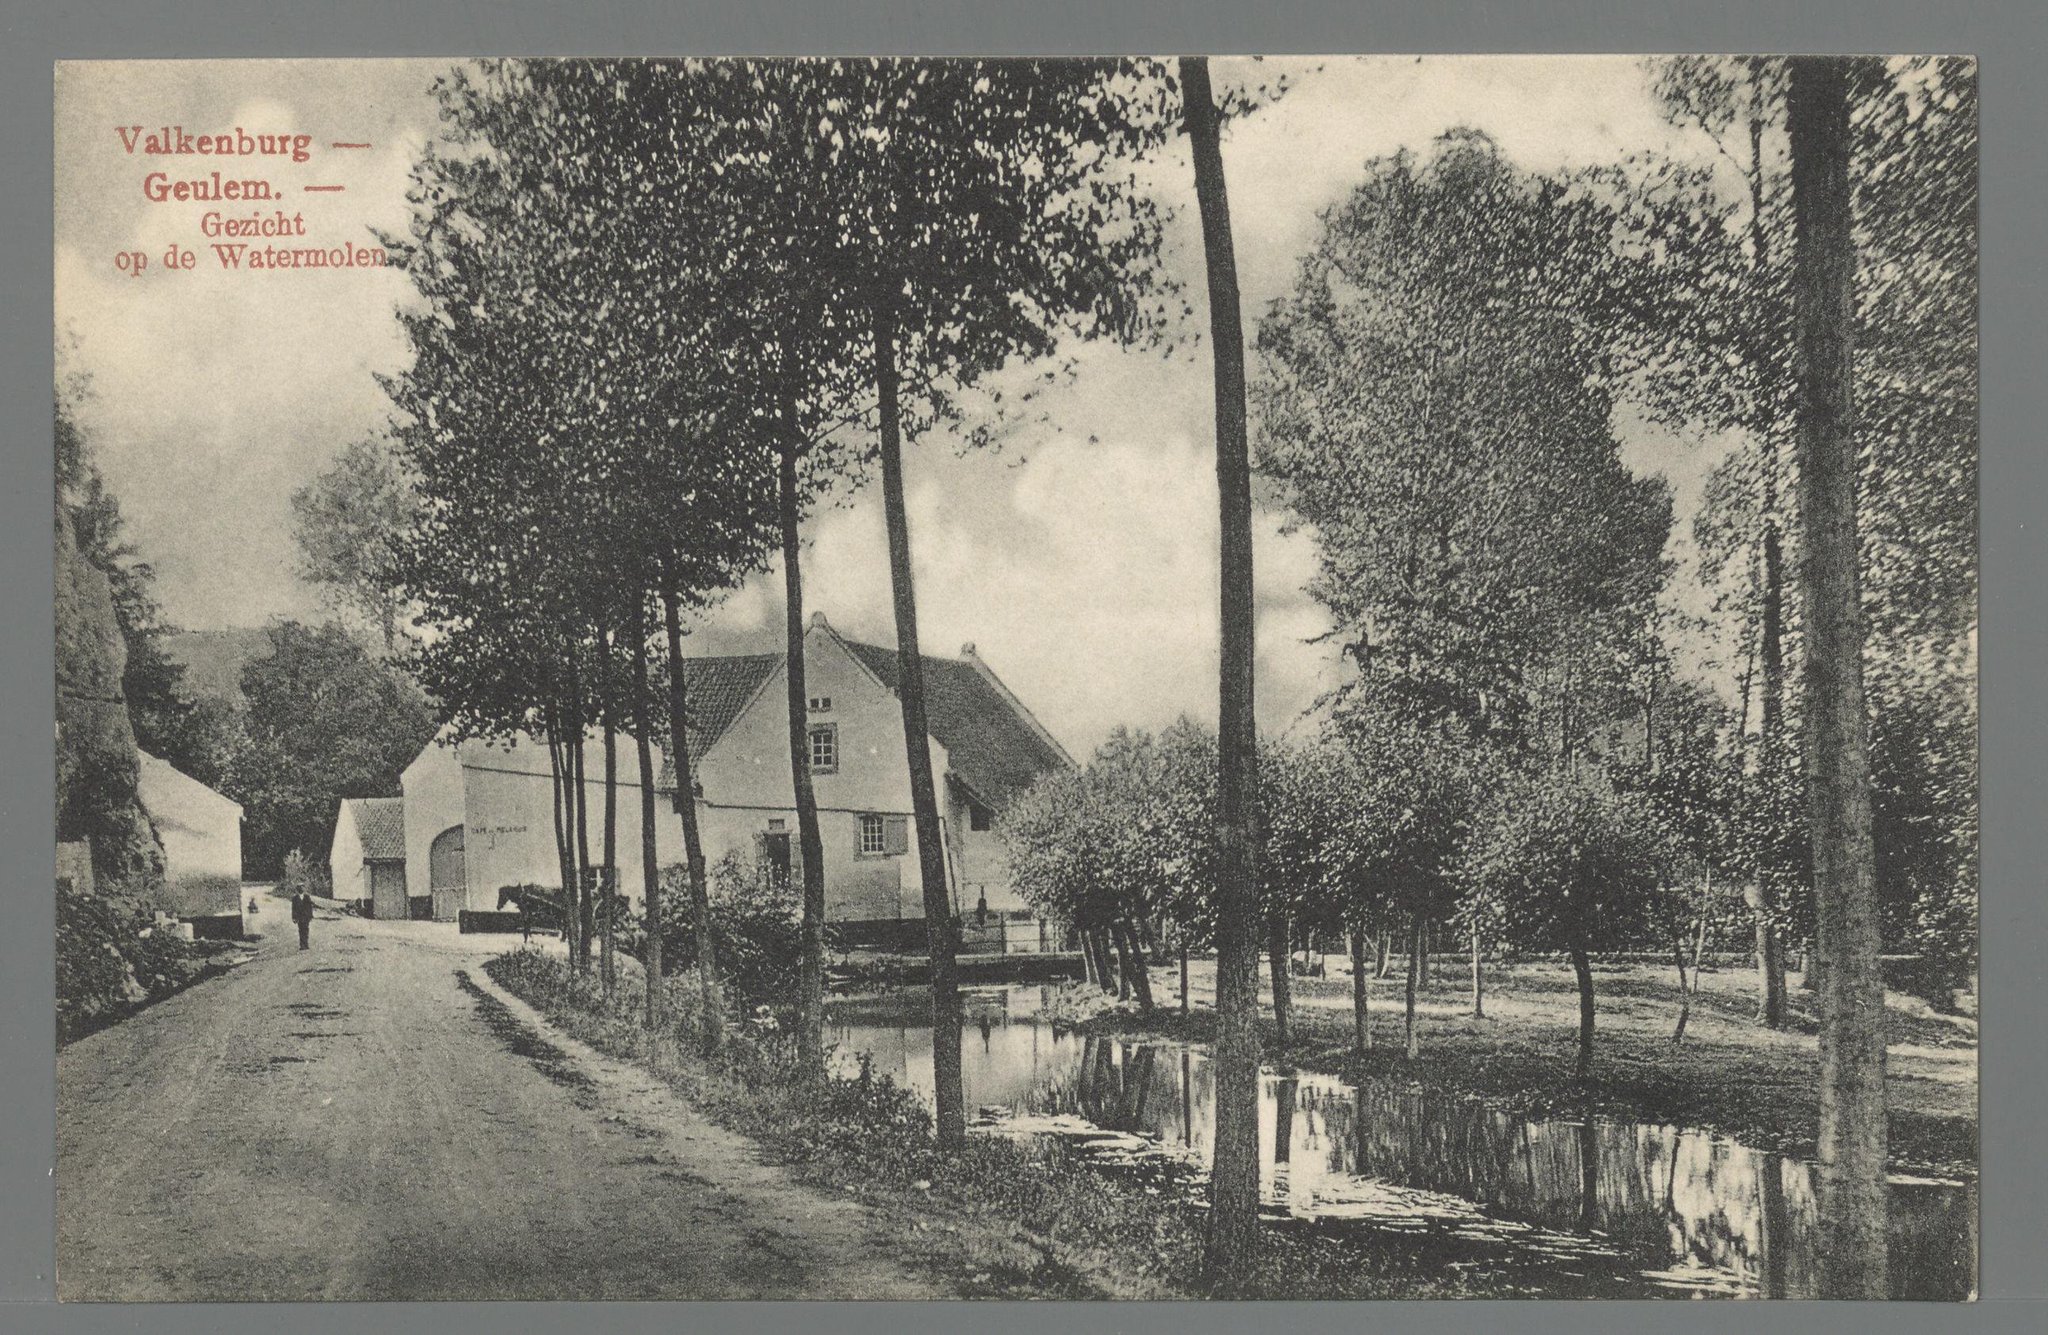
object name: ansichtkaart, prentbriefkaart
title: Valkenburg - Geulem. - Gezicht op de watermolen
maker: Anonymous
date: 1905-1930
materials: cardboard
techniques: photograph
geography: geulhem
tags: canal, watermill in landscape